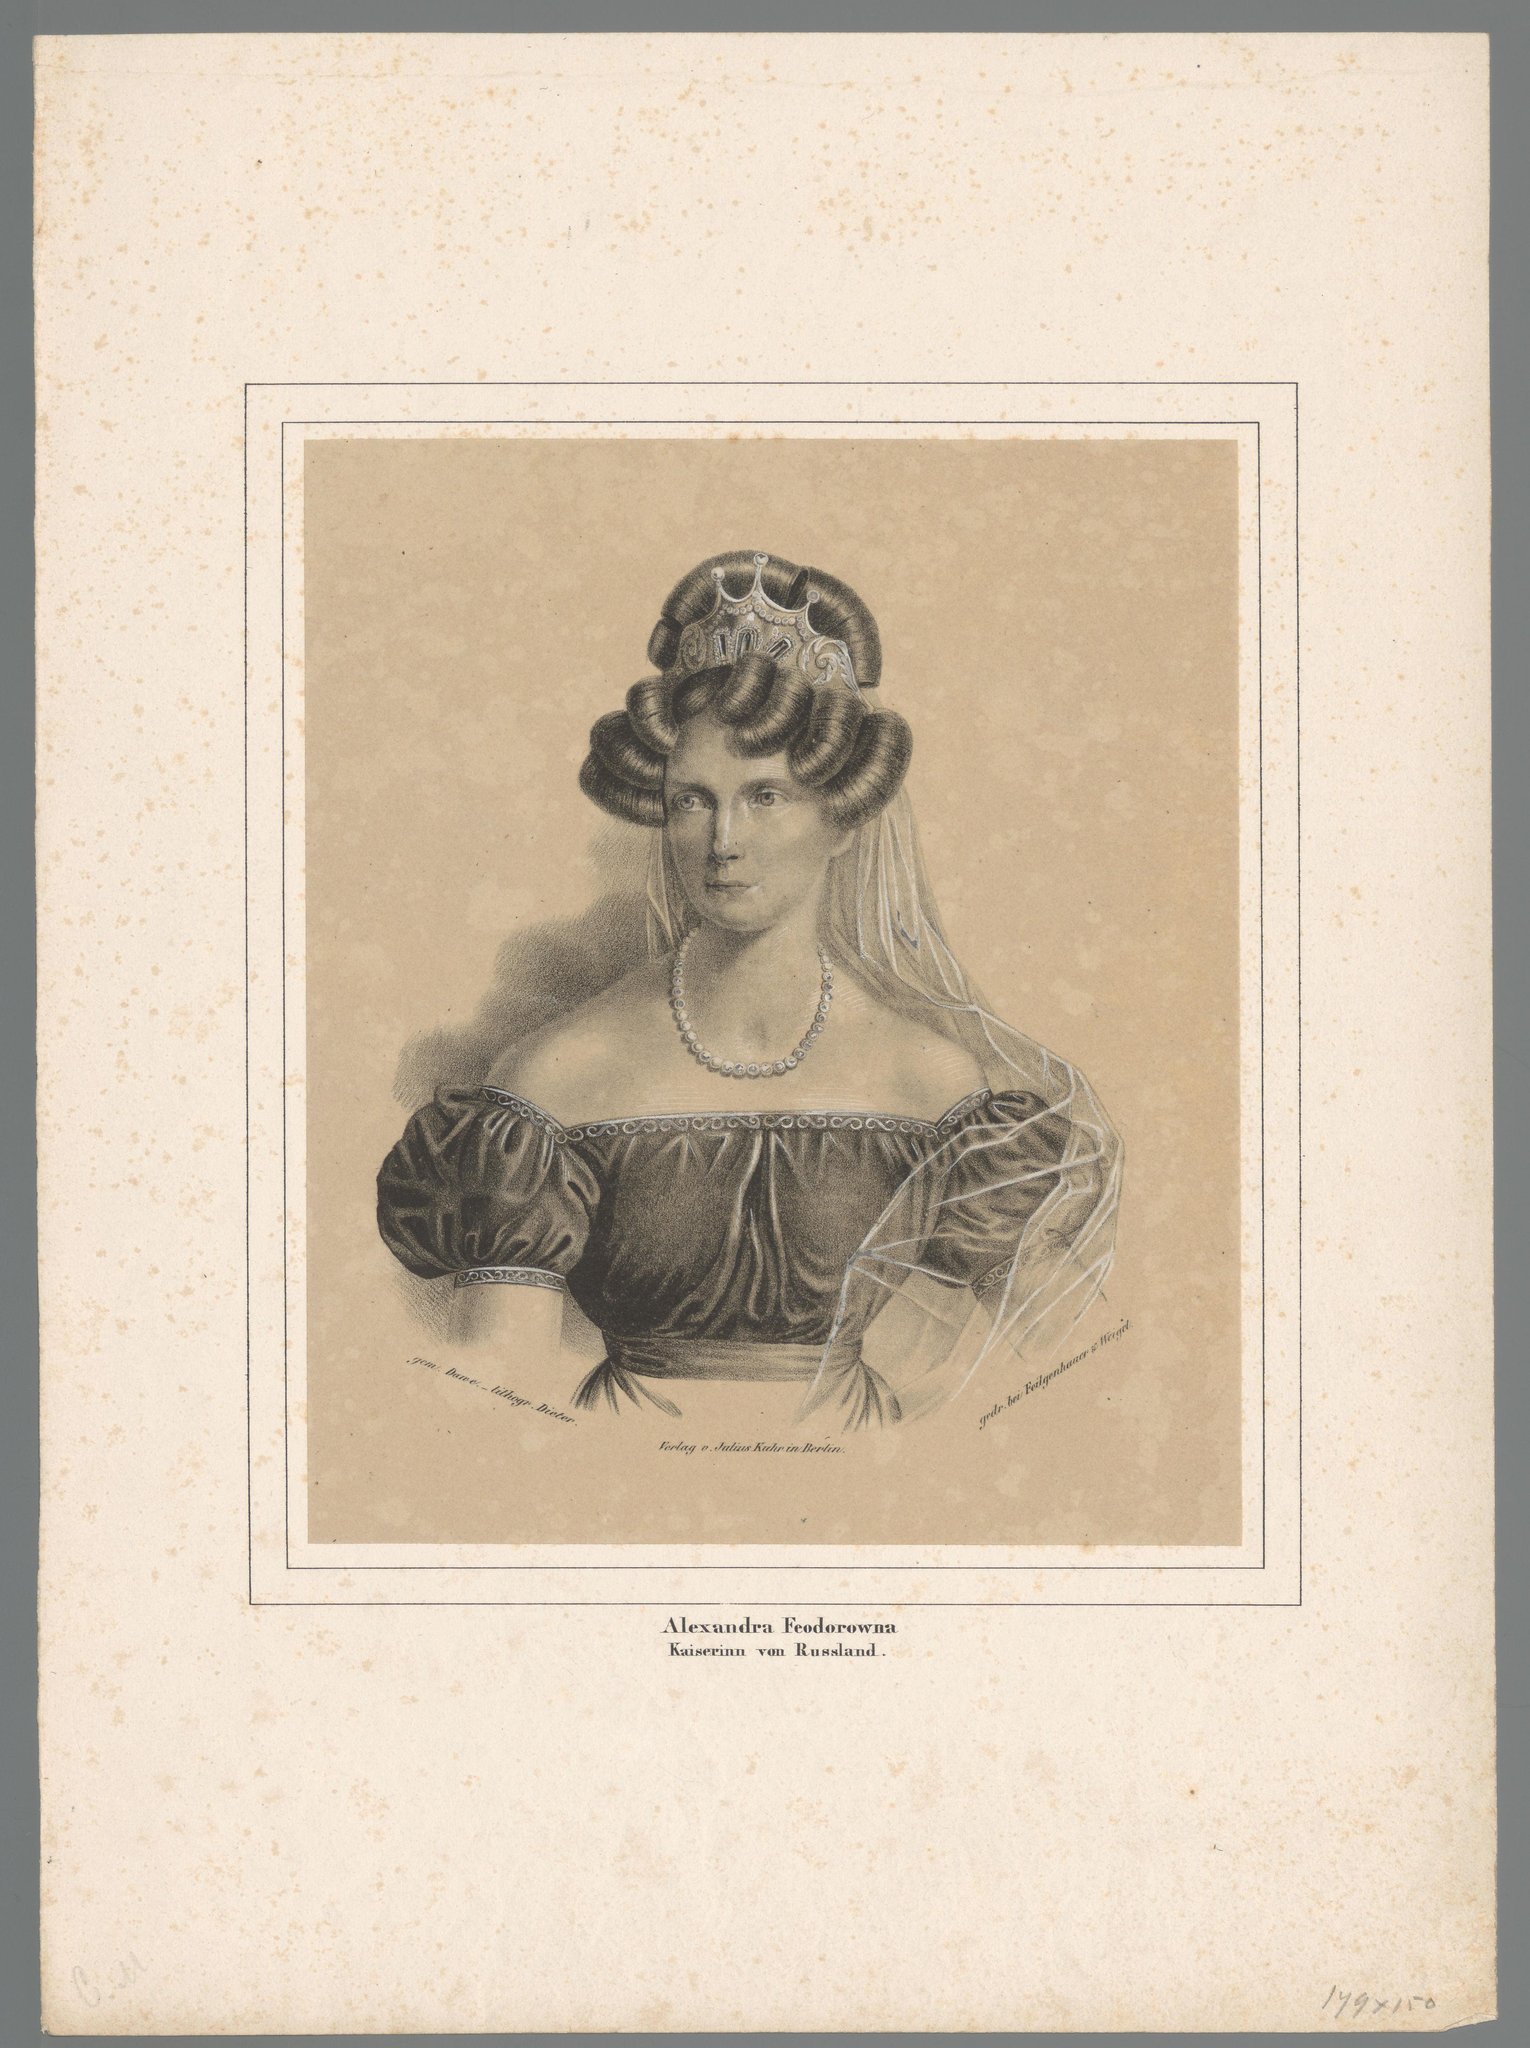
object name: print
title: Alexandra Feodorowna, Kaiserinn von Russland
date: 1820-1840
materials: paper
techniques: tone lithography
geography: berlin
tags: berlin, adult woman, queen, empress, etc. (wife of a ruler), historical persons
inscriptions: collector's mark: Lugt 2228